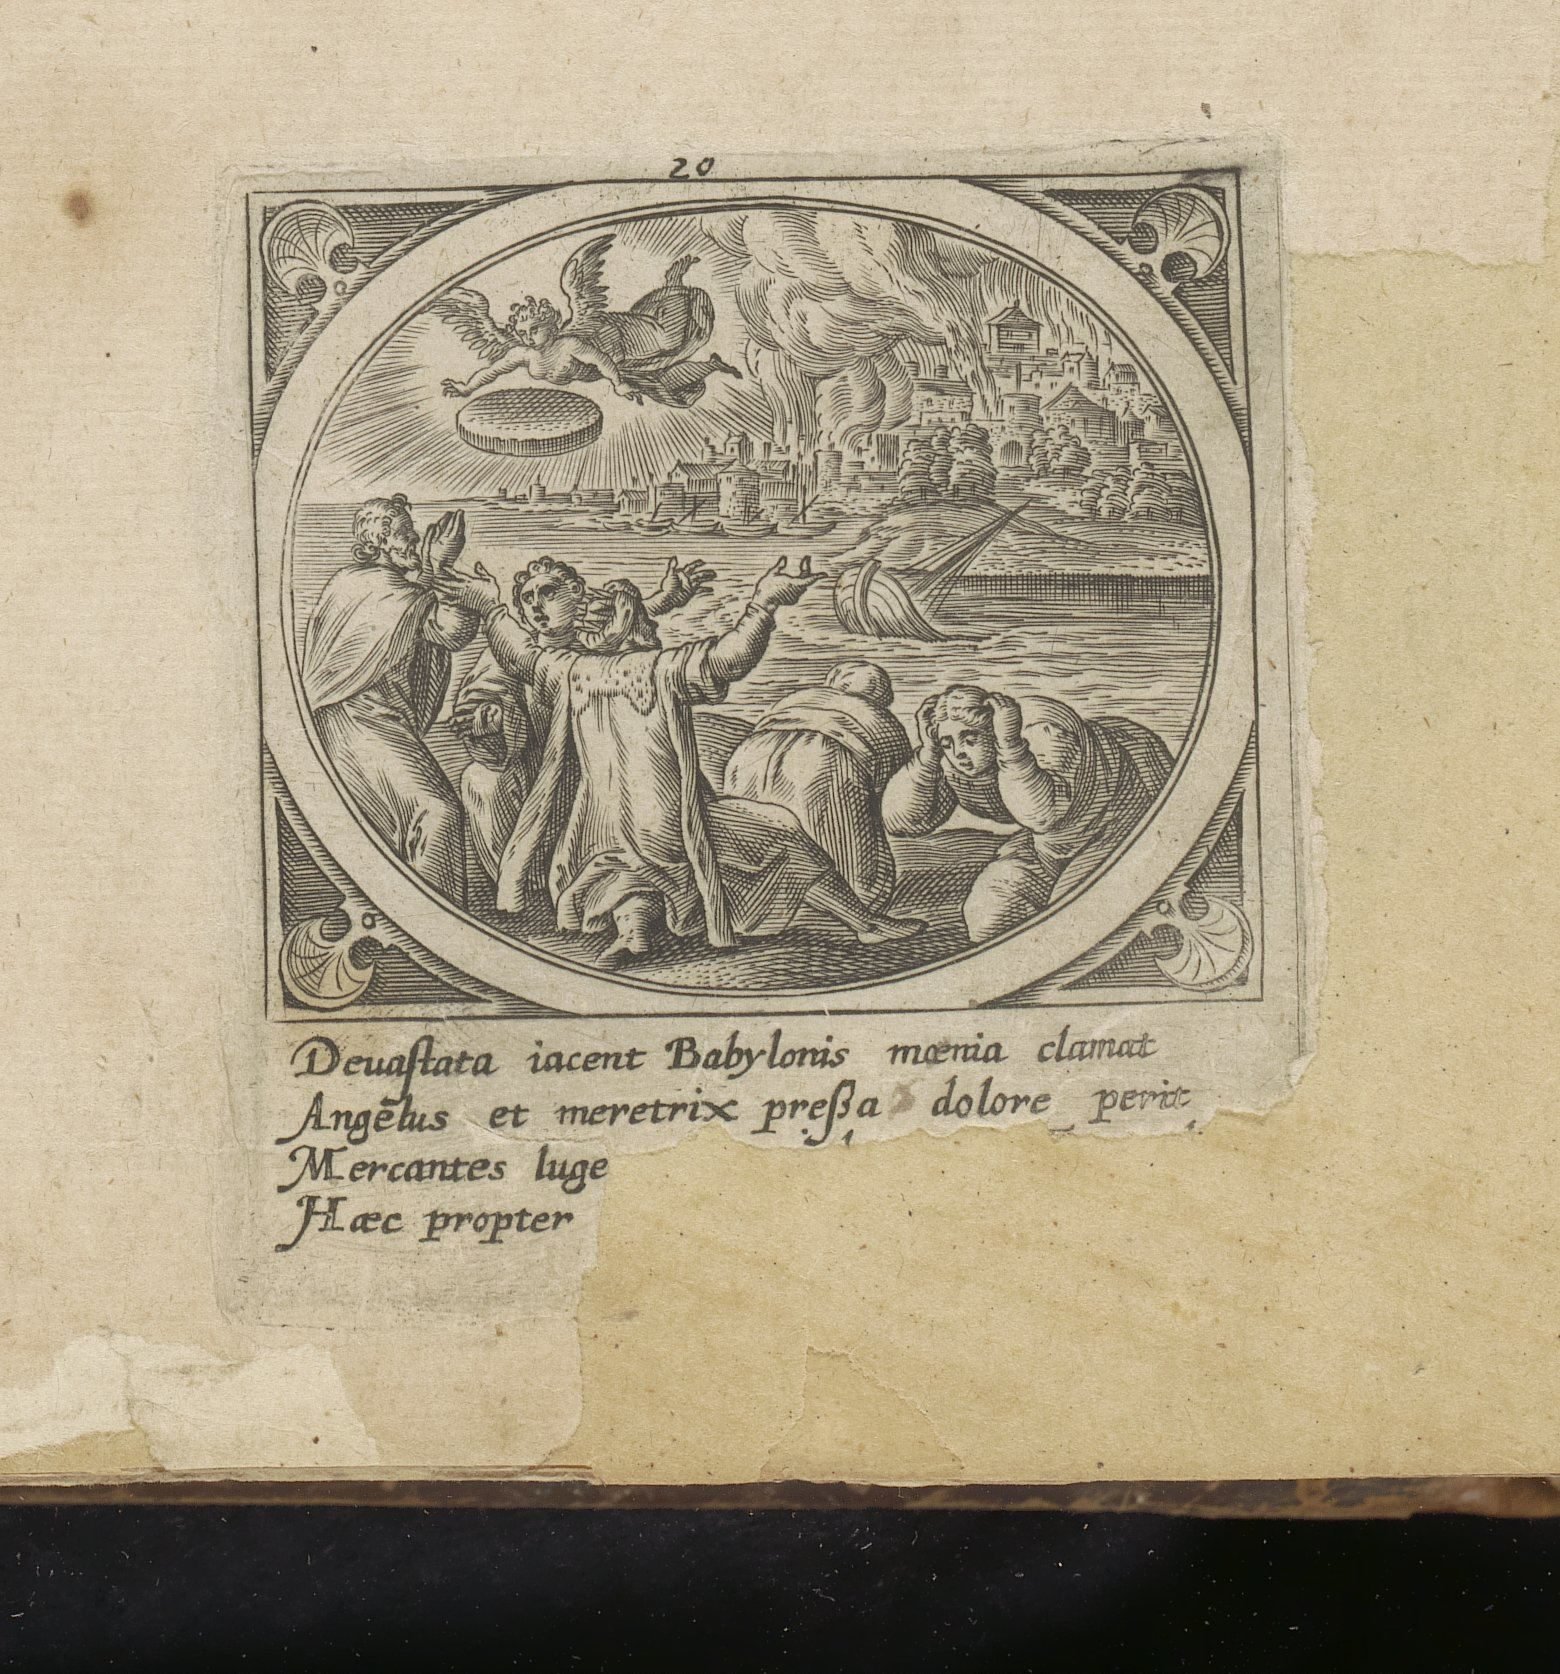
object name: print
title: Den Grooten Figuer-Bibel (...)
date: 1585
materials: paper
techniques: engraving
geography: amsterdam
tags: the fall of babylon, a mighty angel casting a great (mill)stone into the sea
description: Een engel werpt een steen, zo groot als een molensteen, in zee. Op de achtergrond het brandende Babylon. Op de voorgrond rouwende mensen die stof over hun hoofd gooien. Onder de voorstelling een verwijzing in het Latijn naar de Bijbeltekst in Op. 18:1. Deze prent maakt deel uit van een album.